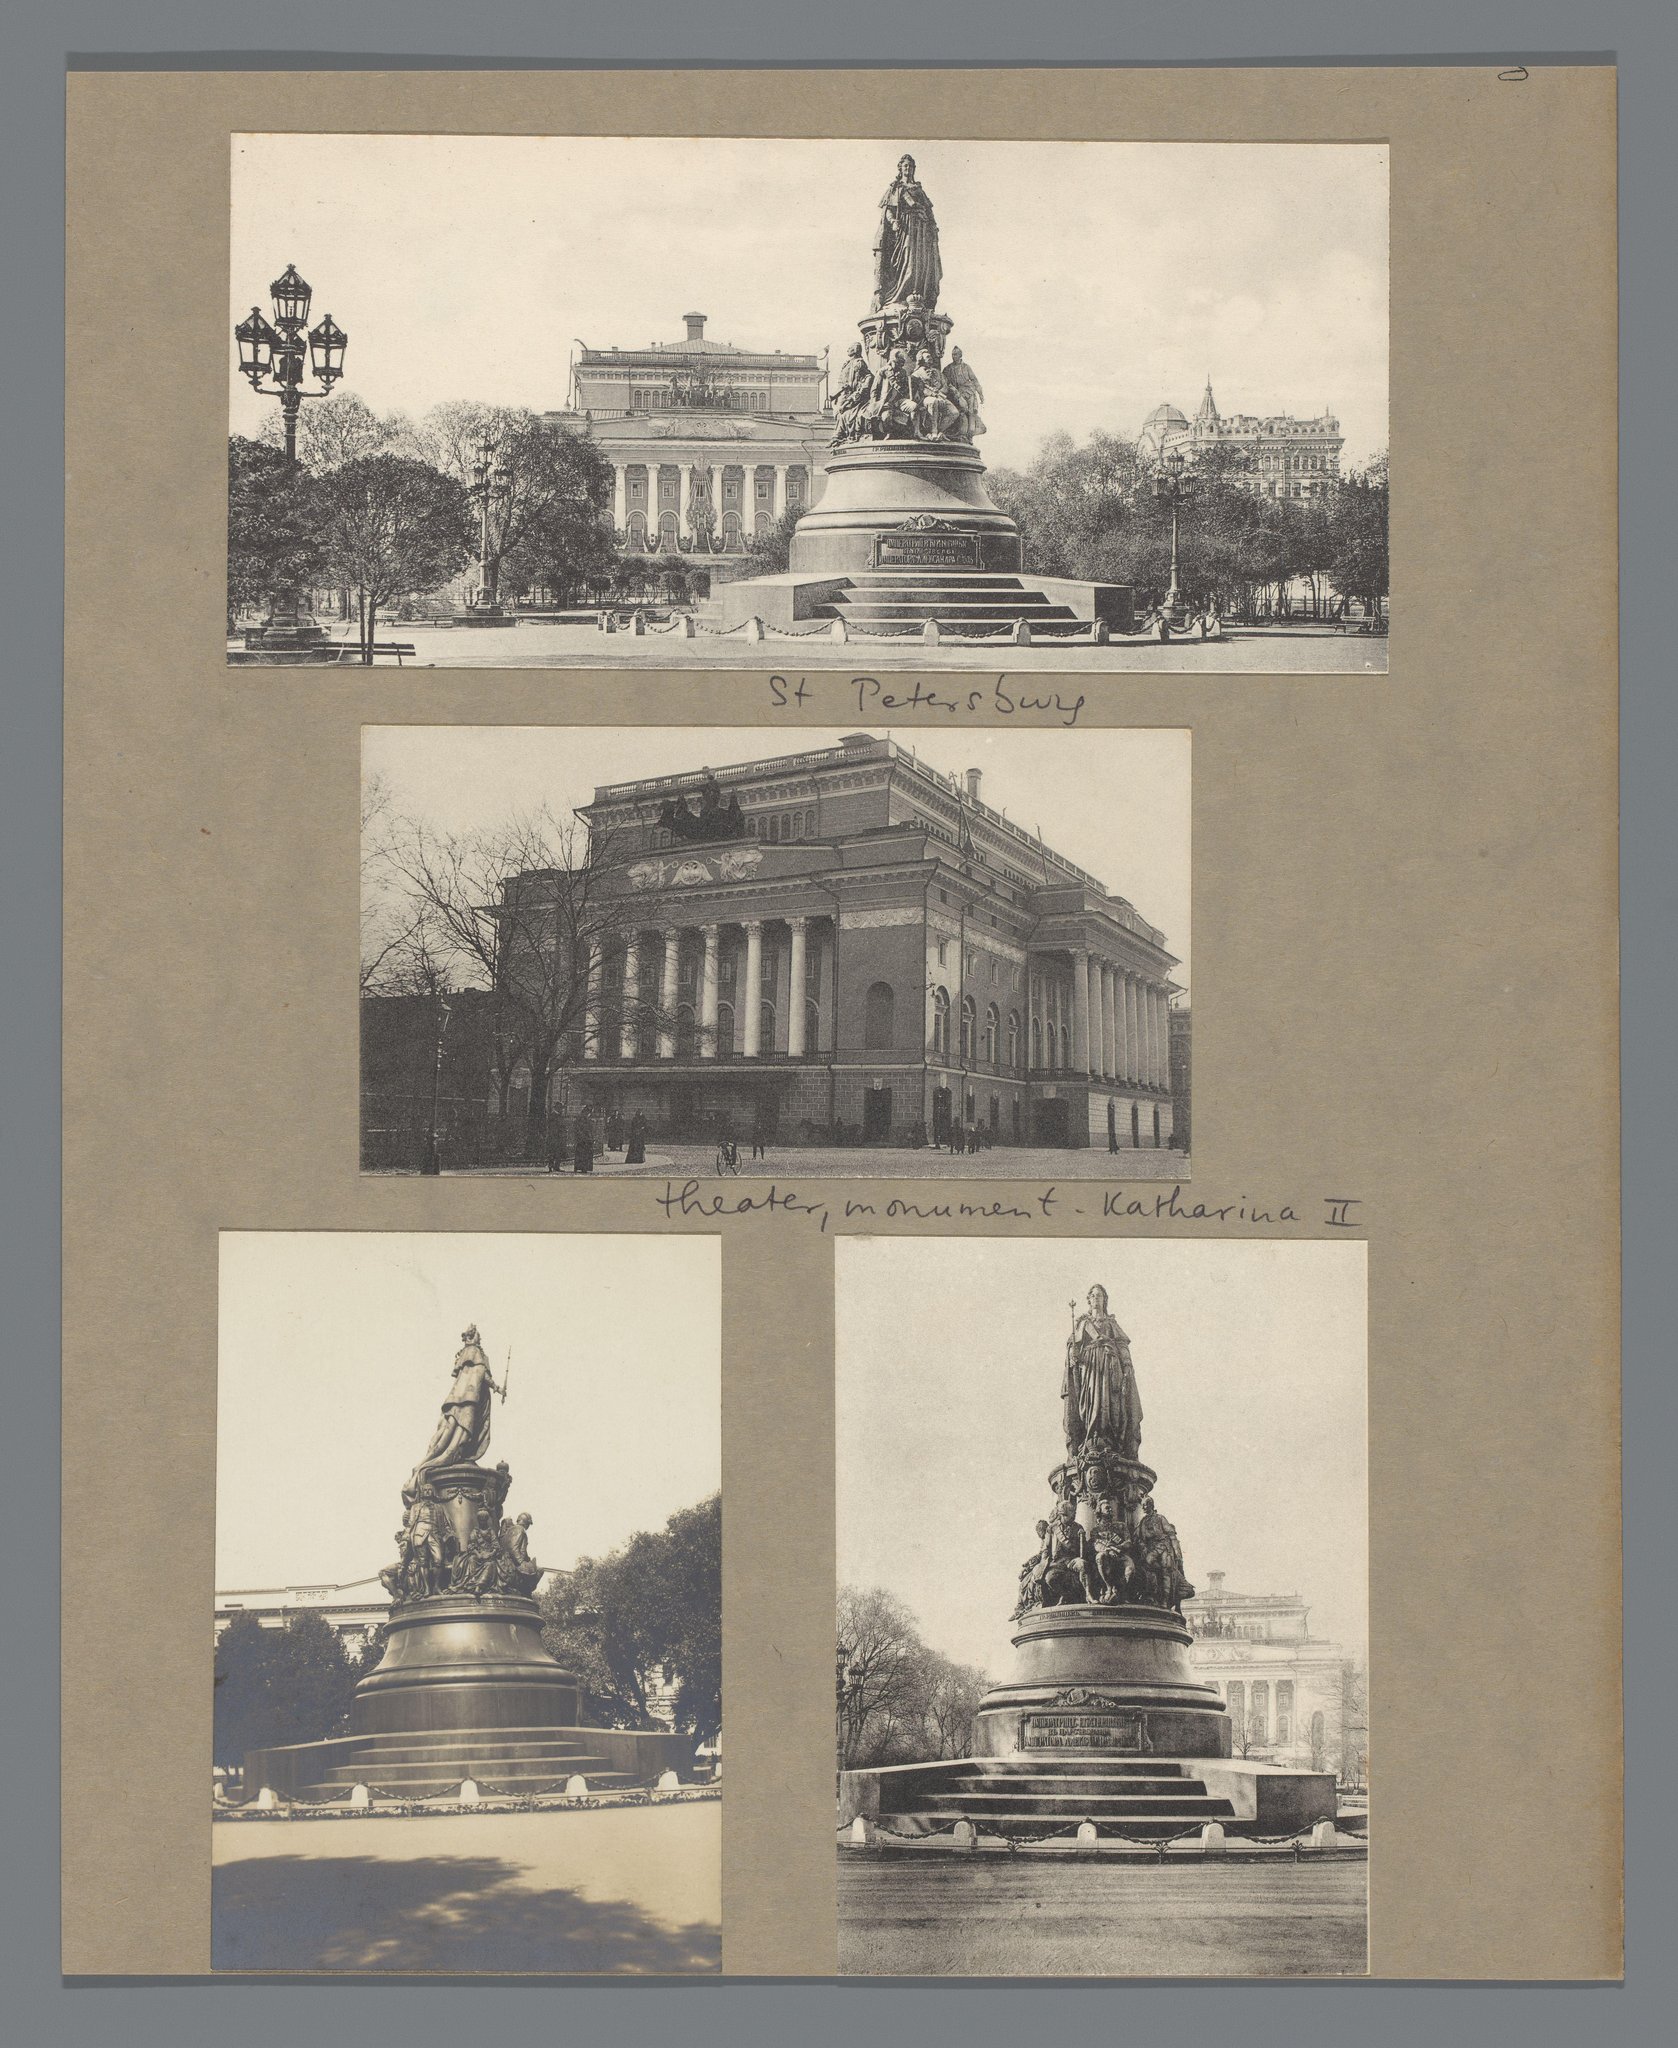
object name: photograph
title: St. Petersburg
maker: Anonymous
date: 1880-1930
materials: photographic support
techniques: photograph, gelatin silver print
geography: russia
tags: sint-petersburg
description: Vier foto's van Sint-Petersburg op drager.